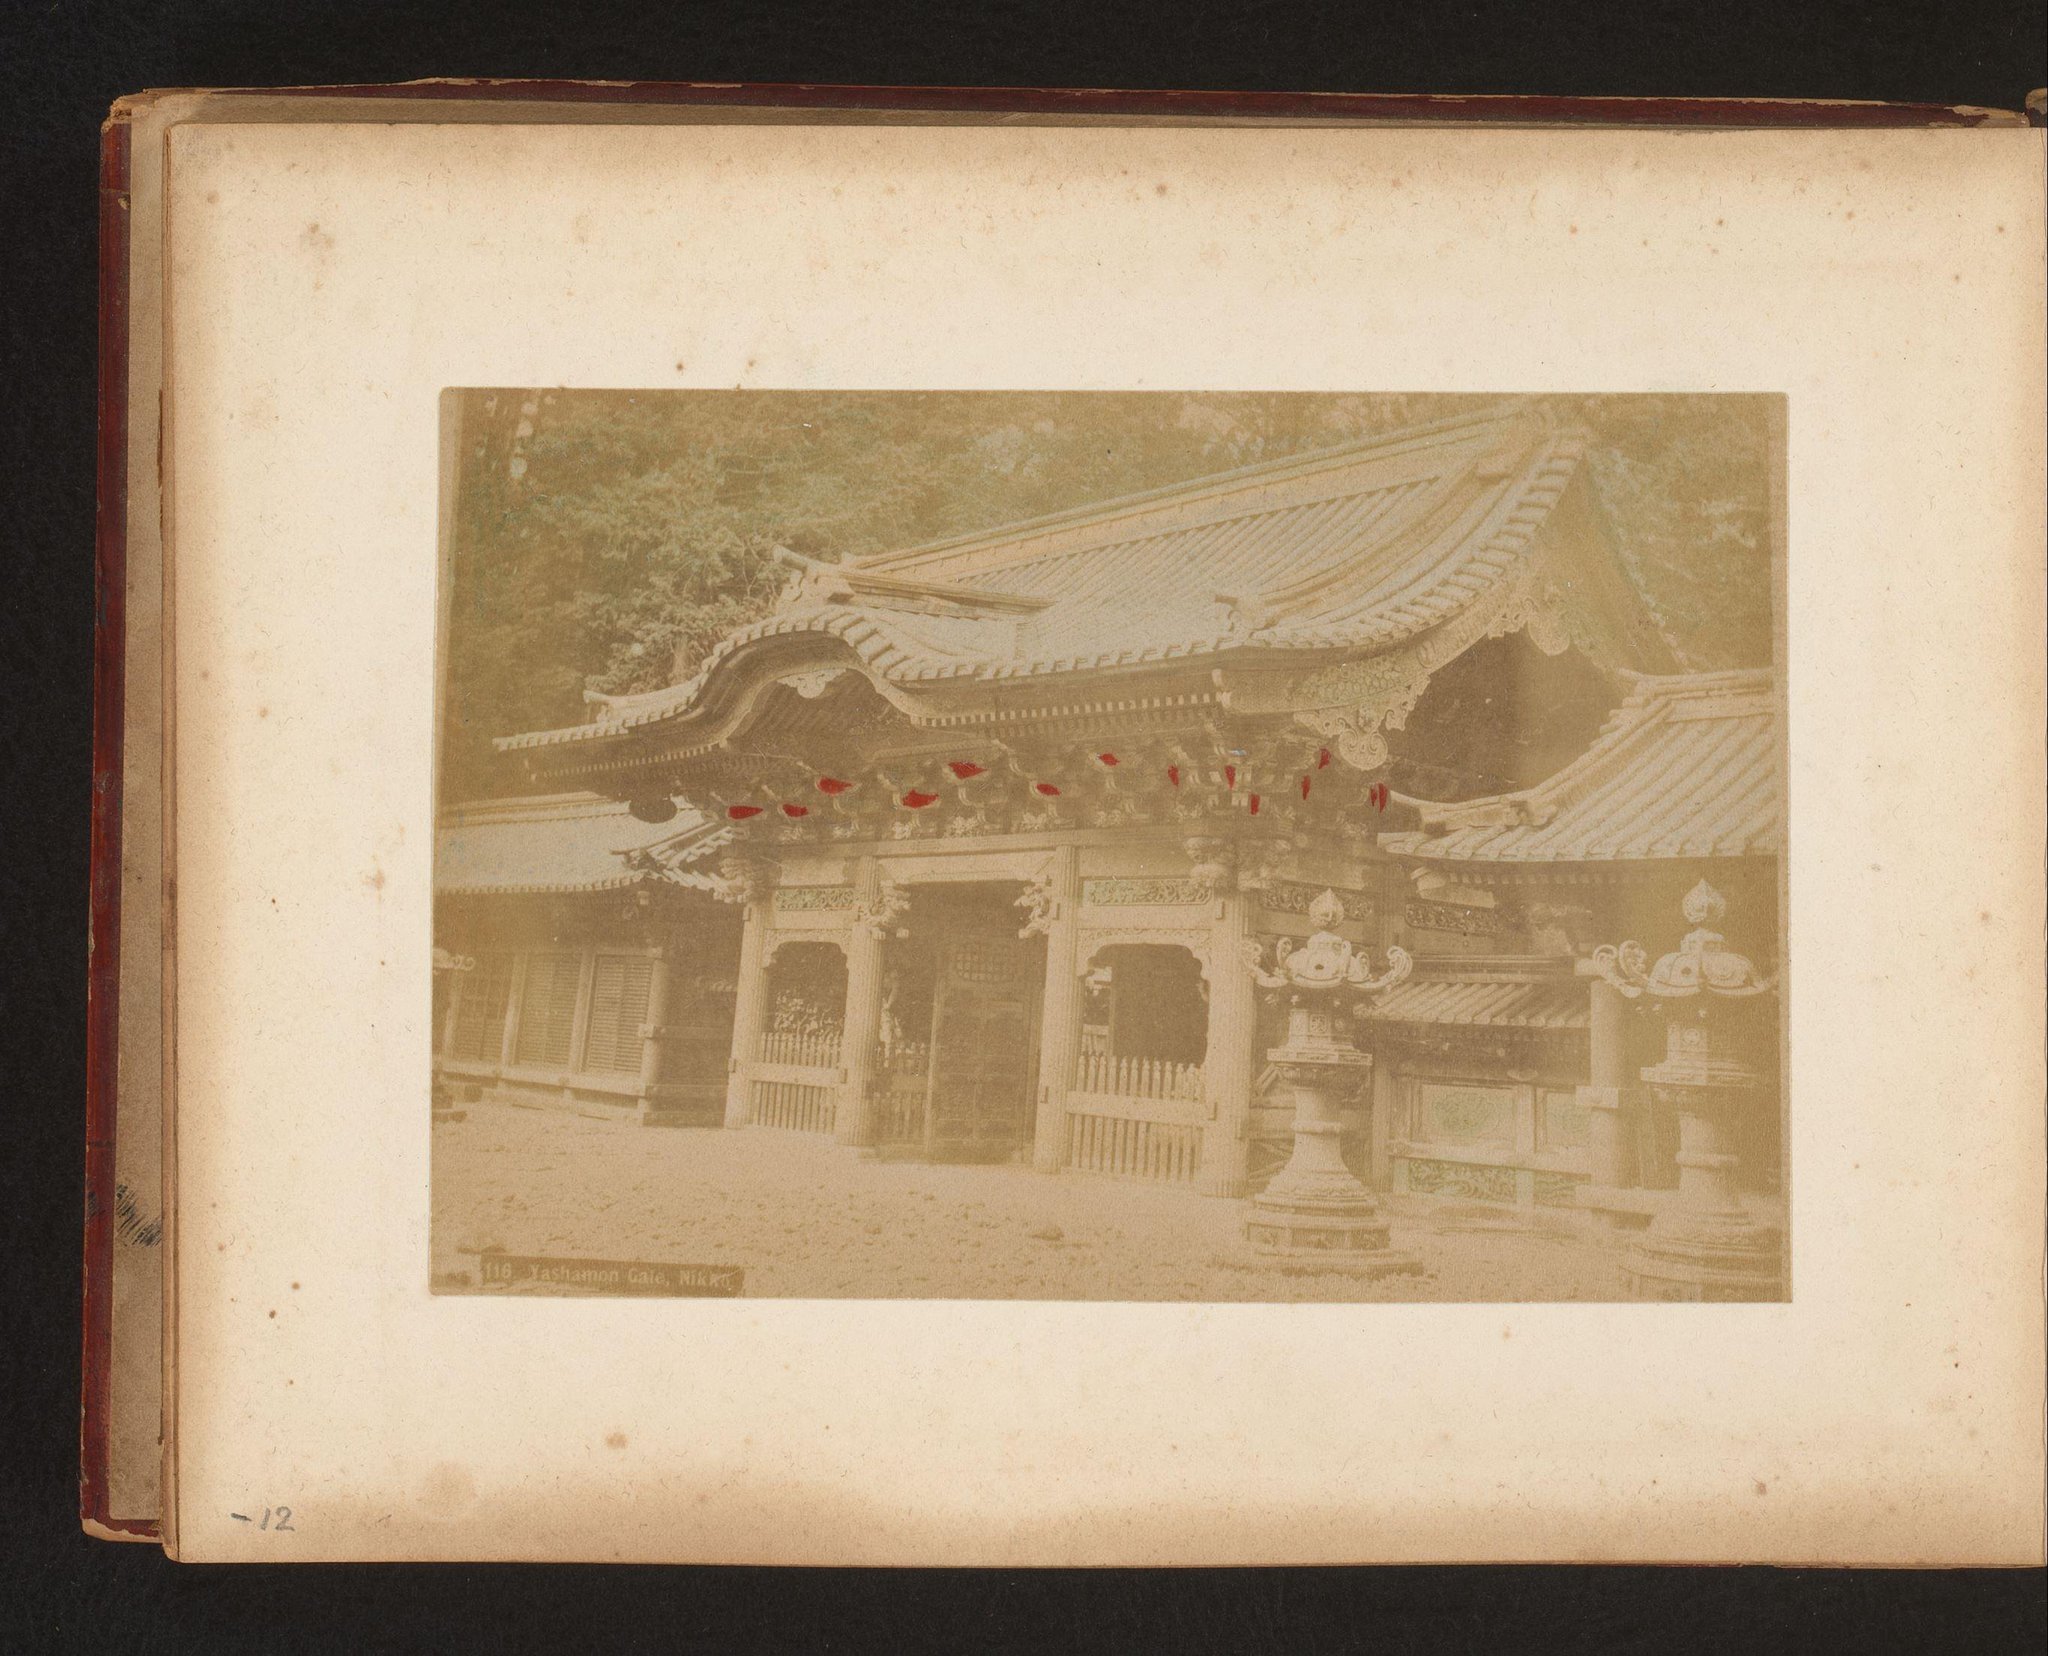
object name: album leaf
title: Entrée van het mausoleum ter herinnering aan Tokugawa Iemitsu in de Taiyuinbyo in Nikko, Japan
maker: Anonymous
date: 1851-1900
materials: paper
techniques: albumen print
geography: nikko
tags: temple, shrine ~ shinto, mausoleum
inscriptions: number: ‘116’